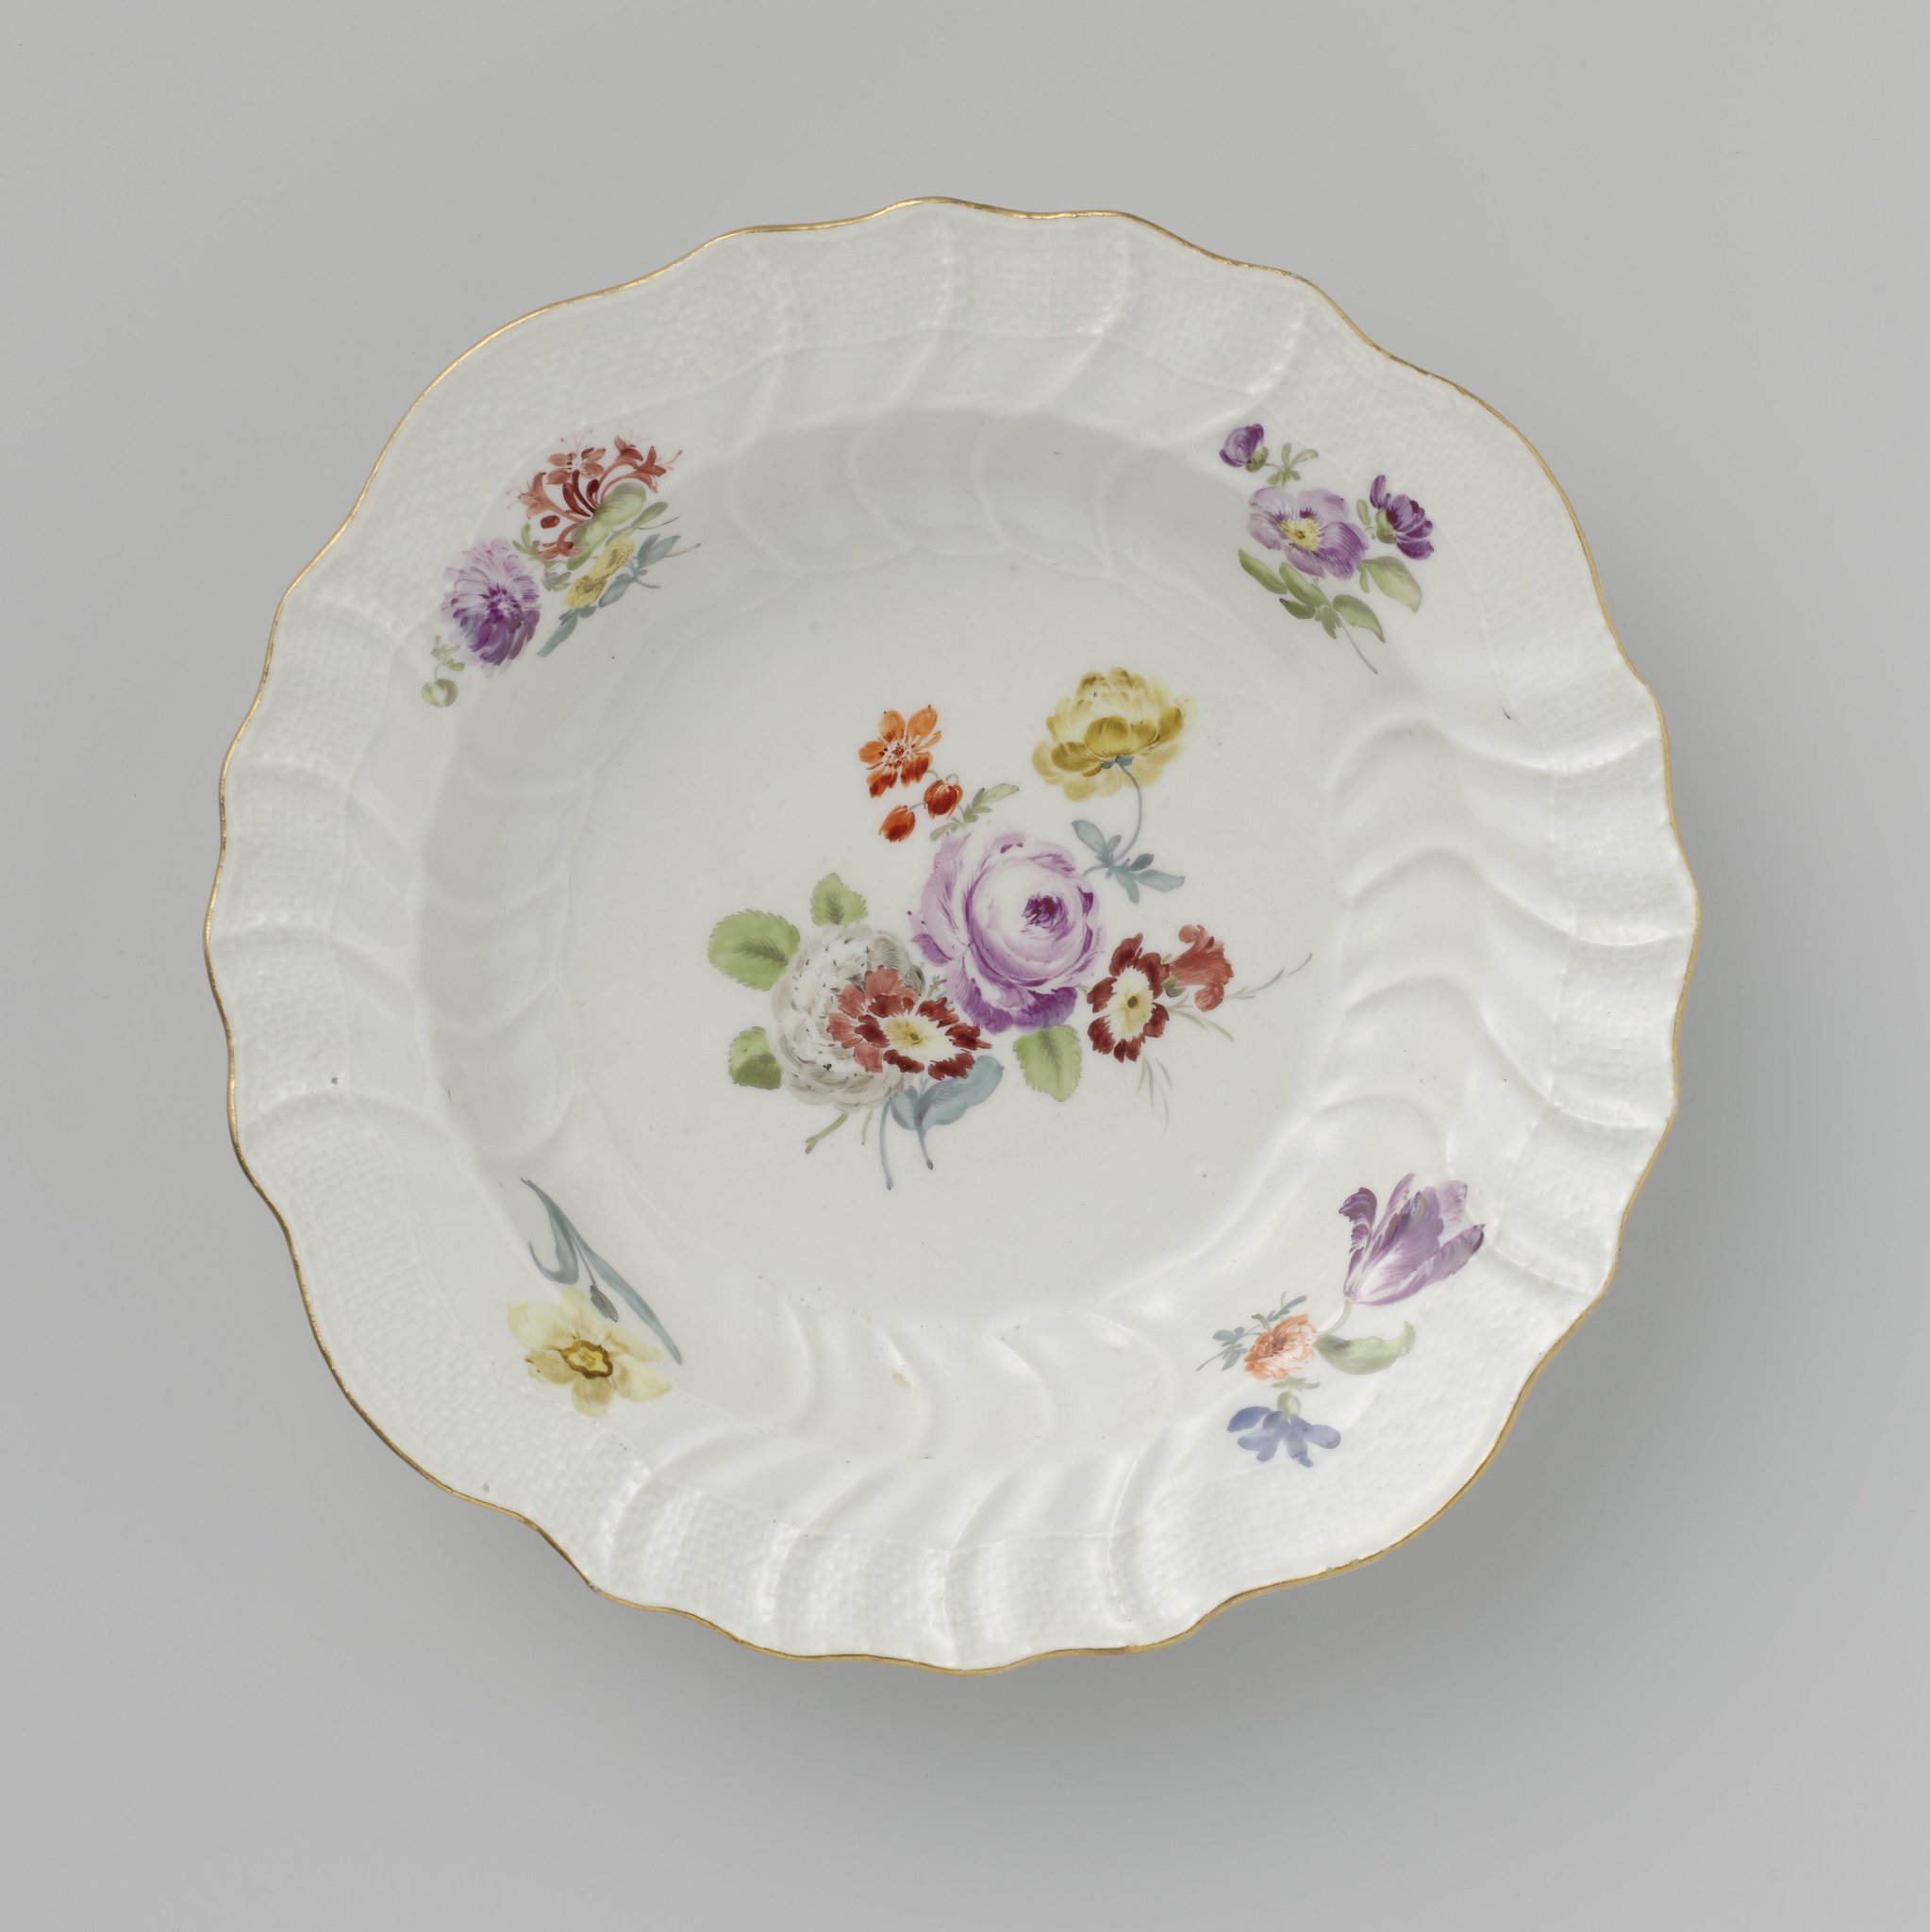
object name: eating drinking utensil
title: Bord, veelkleurig beschilderd met Deutsche Blumen, insekten en vruchten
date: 1750-1760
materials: porcelain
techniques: painted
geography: meissen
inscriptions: factory mark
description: Rond soepbord van beschilderd porselein. Het bord is beschilderd met Deutsche Blumen, insekten en vruchten. De rand is in reliëf versierd met het Neuozier-patroon. Het bord is gemerkt en hoort bij een servies (BK-17474-1 t/m BK-17474-253).